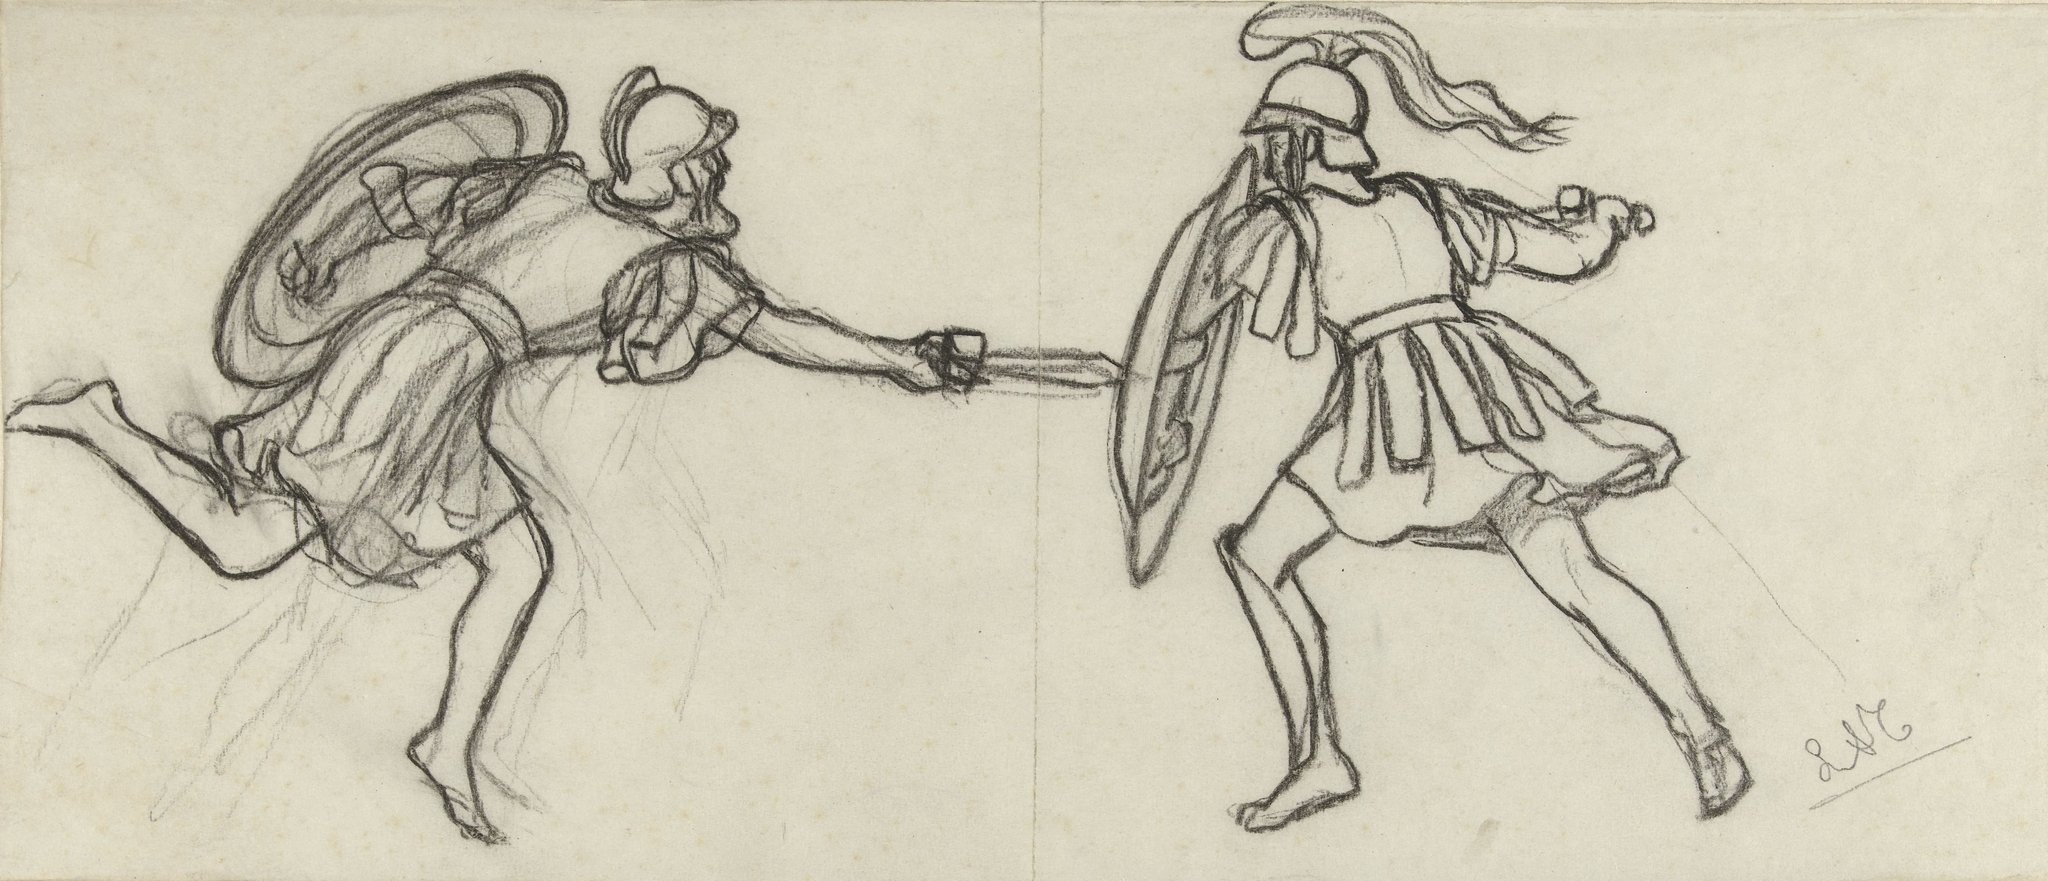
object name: drawing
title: Twee strijdende gymnasiasten met helmen op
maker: lourens alma tadema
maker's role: draughtsman, print maker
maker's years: 1836-1912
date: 1846-1912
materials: chalk, paper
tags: sport-tournament, fighting contest (sport)